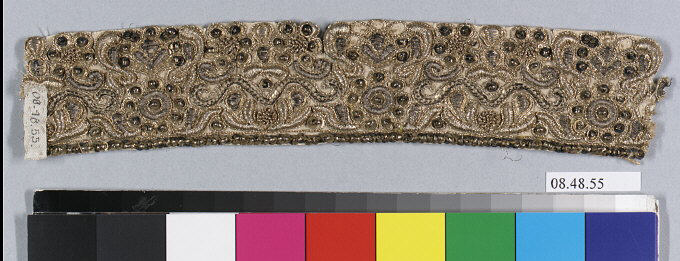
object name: fragment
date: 1501-1700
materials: metal thread